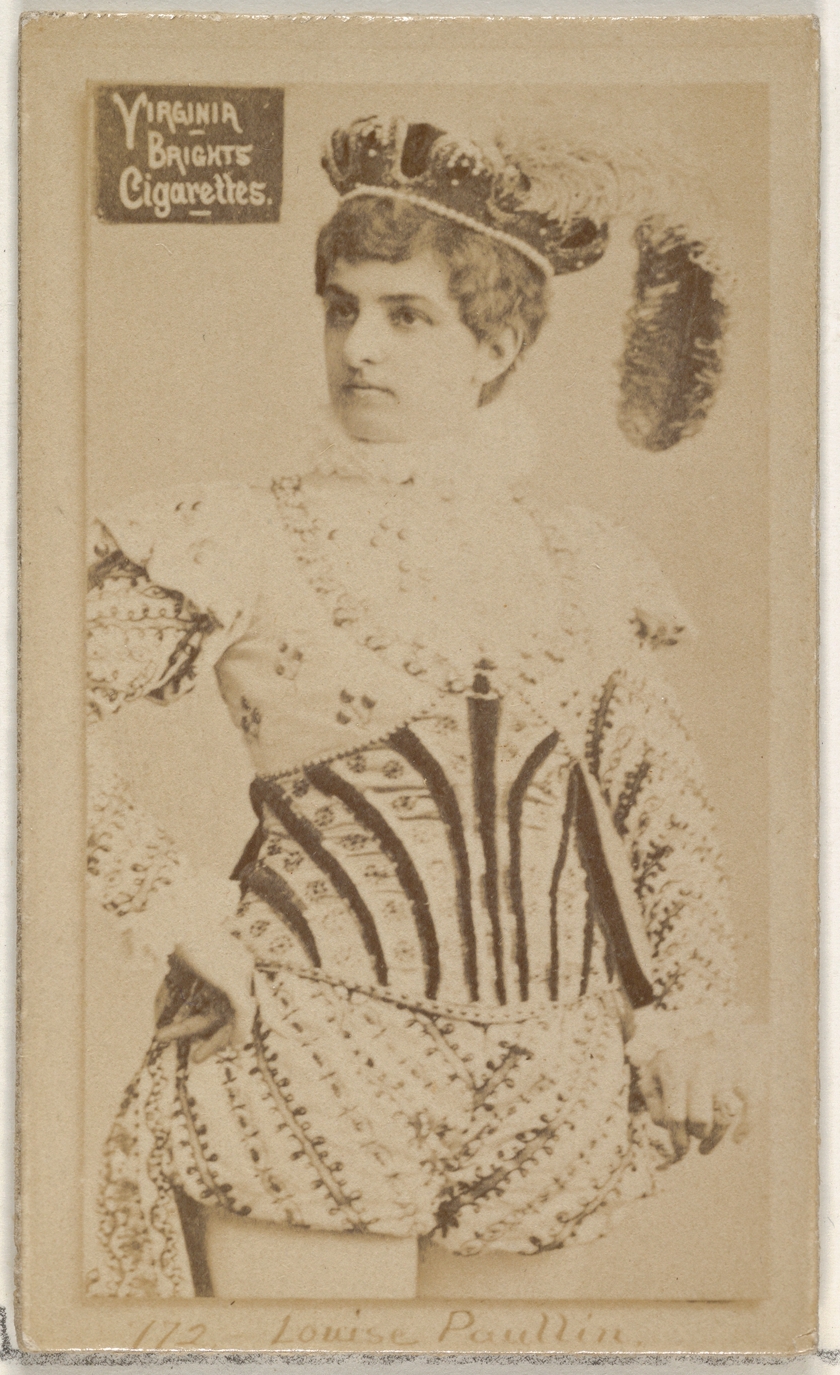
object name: photograph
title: Card 772, Louise Paullin, from the Actors and Actresses series (N45, Type 2) for Virginia Brights Cigarettes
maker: allen & ginter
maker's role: publisher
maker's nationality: american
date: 1888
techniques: albumen silver print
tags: portraits,women,actresses